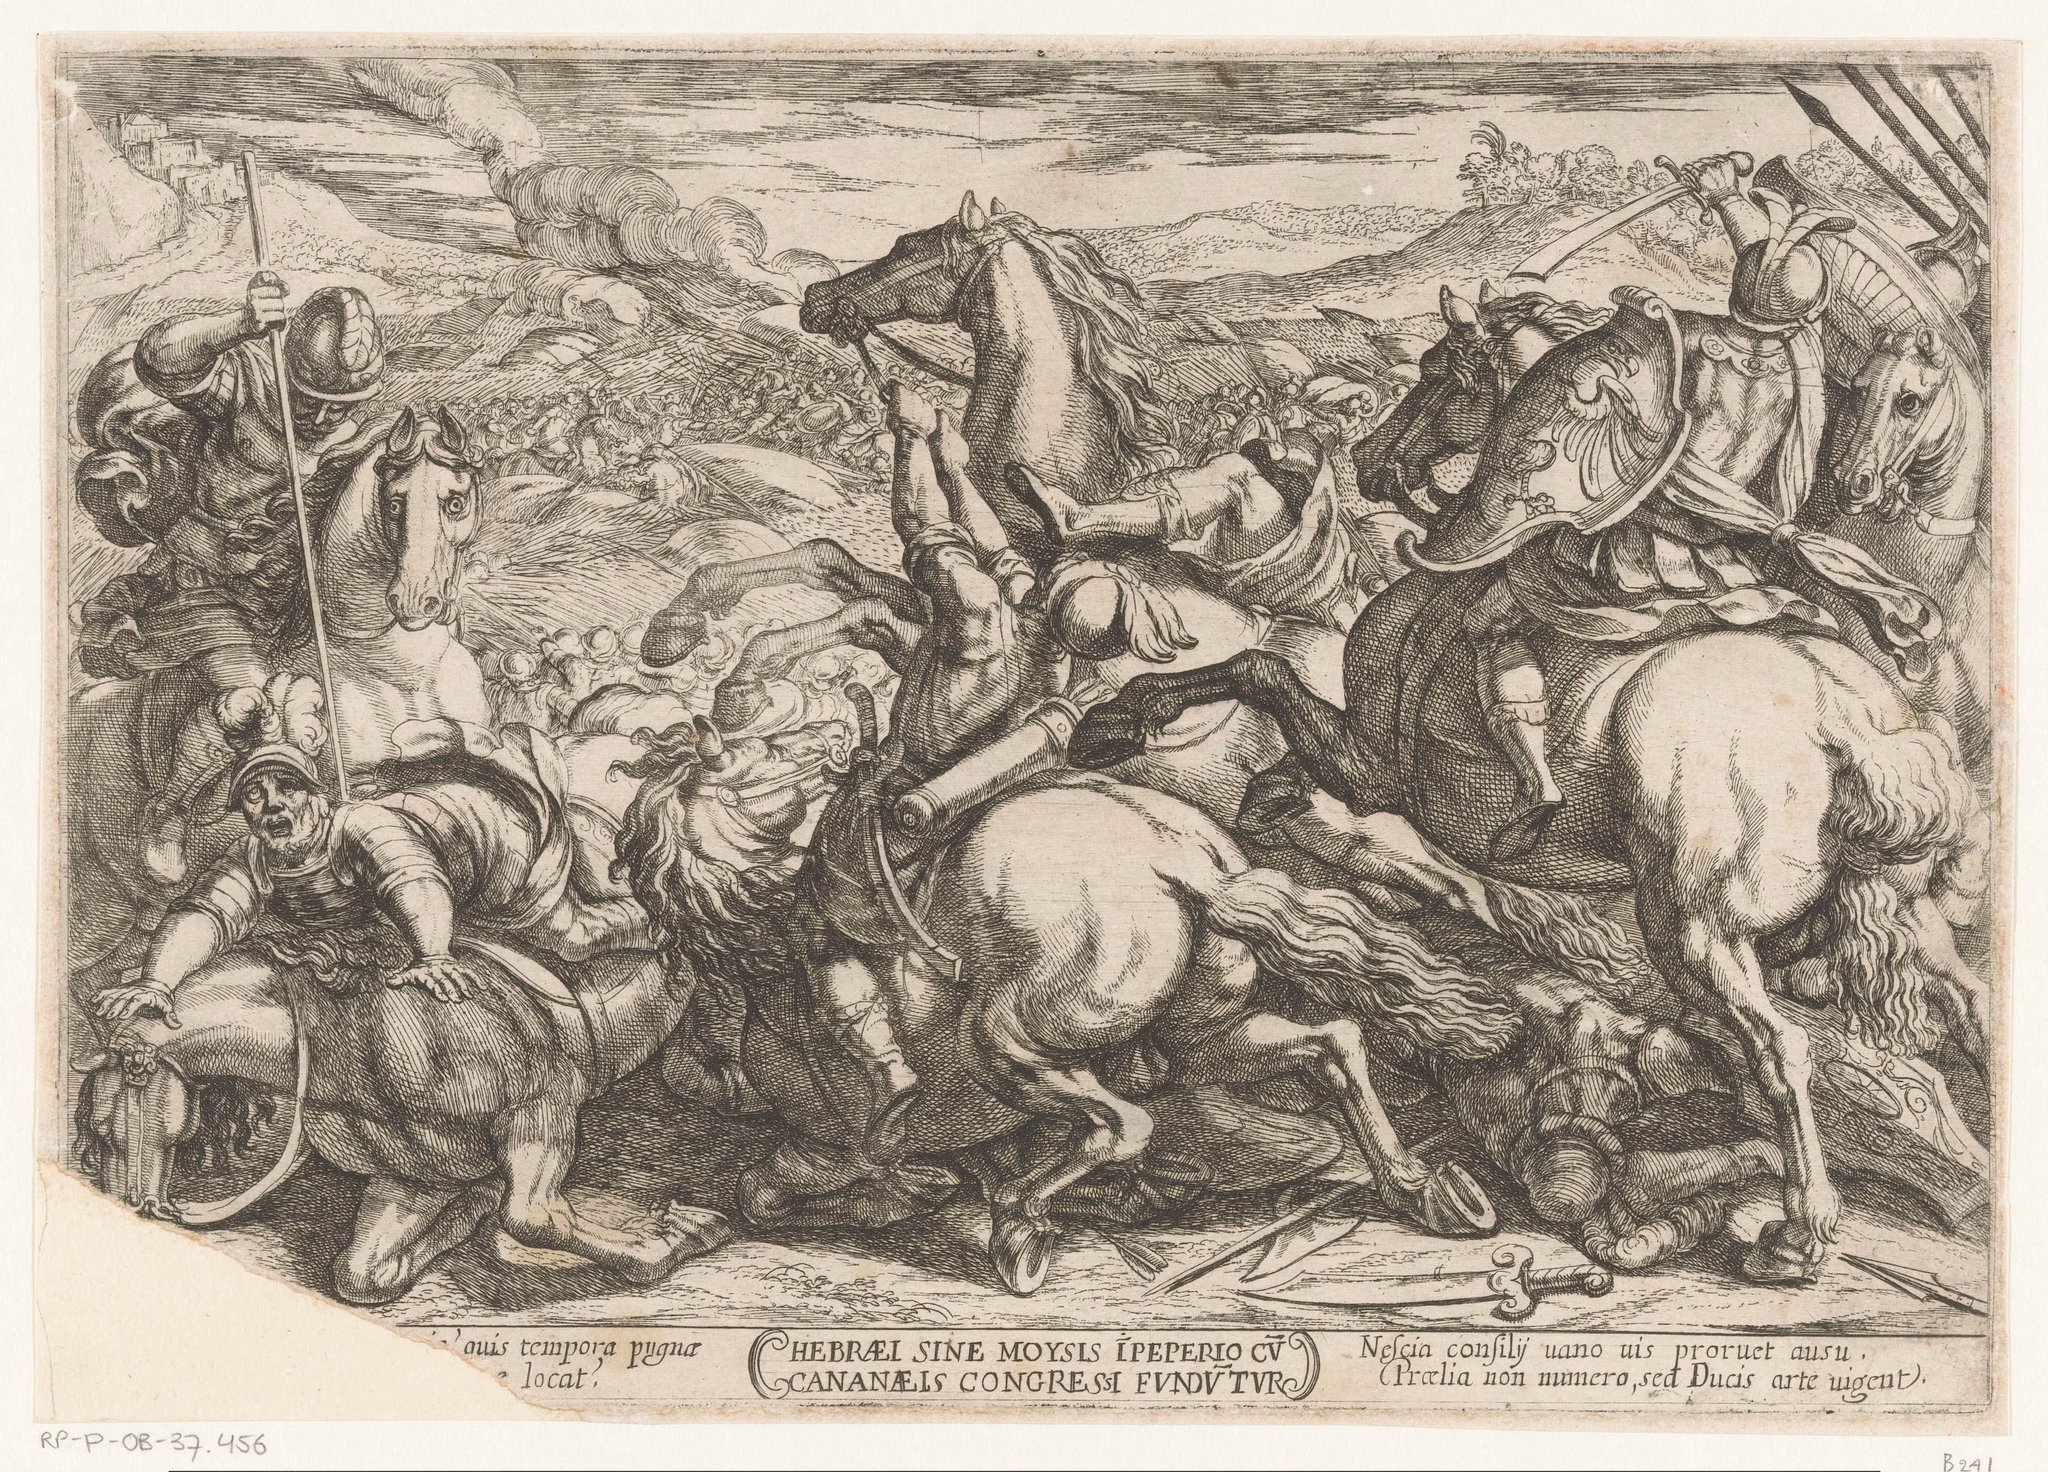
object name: print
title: De Israëlieten verslagen door de Kanaänieten omdat ze Mozes niet gehoorzaamd hebben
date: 1613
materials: paper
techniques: etching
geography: rome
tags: the first attempt to invade canaan fails: the israelites are smitten by the amalekites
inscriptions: collector's mark: Lugt 240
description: Een strijdgewoel van soldaten te paard. De Israëlieten worden verslagen door de Kanaänieten omdat ze Mozes niet gehoorzaamd hebben. Titel en onderschrift in het Latijn in de ondermarge. Oorspronkelijk genummerd 6 in voorstelling linksonder, maar hier is de hoek afgescheurd.